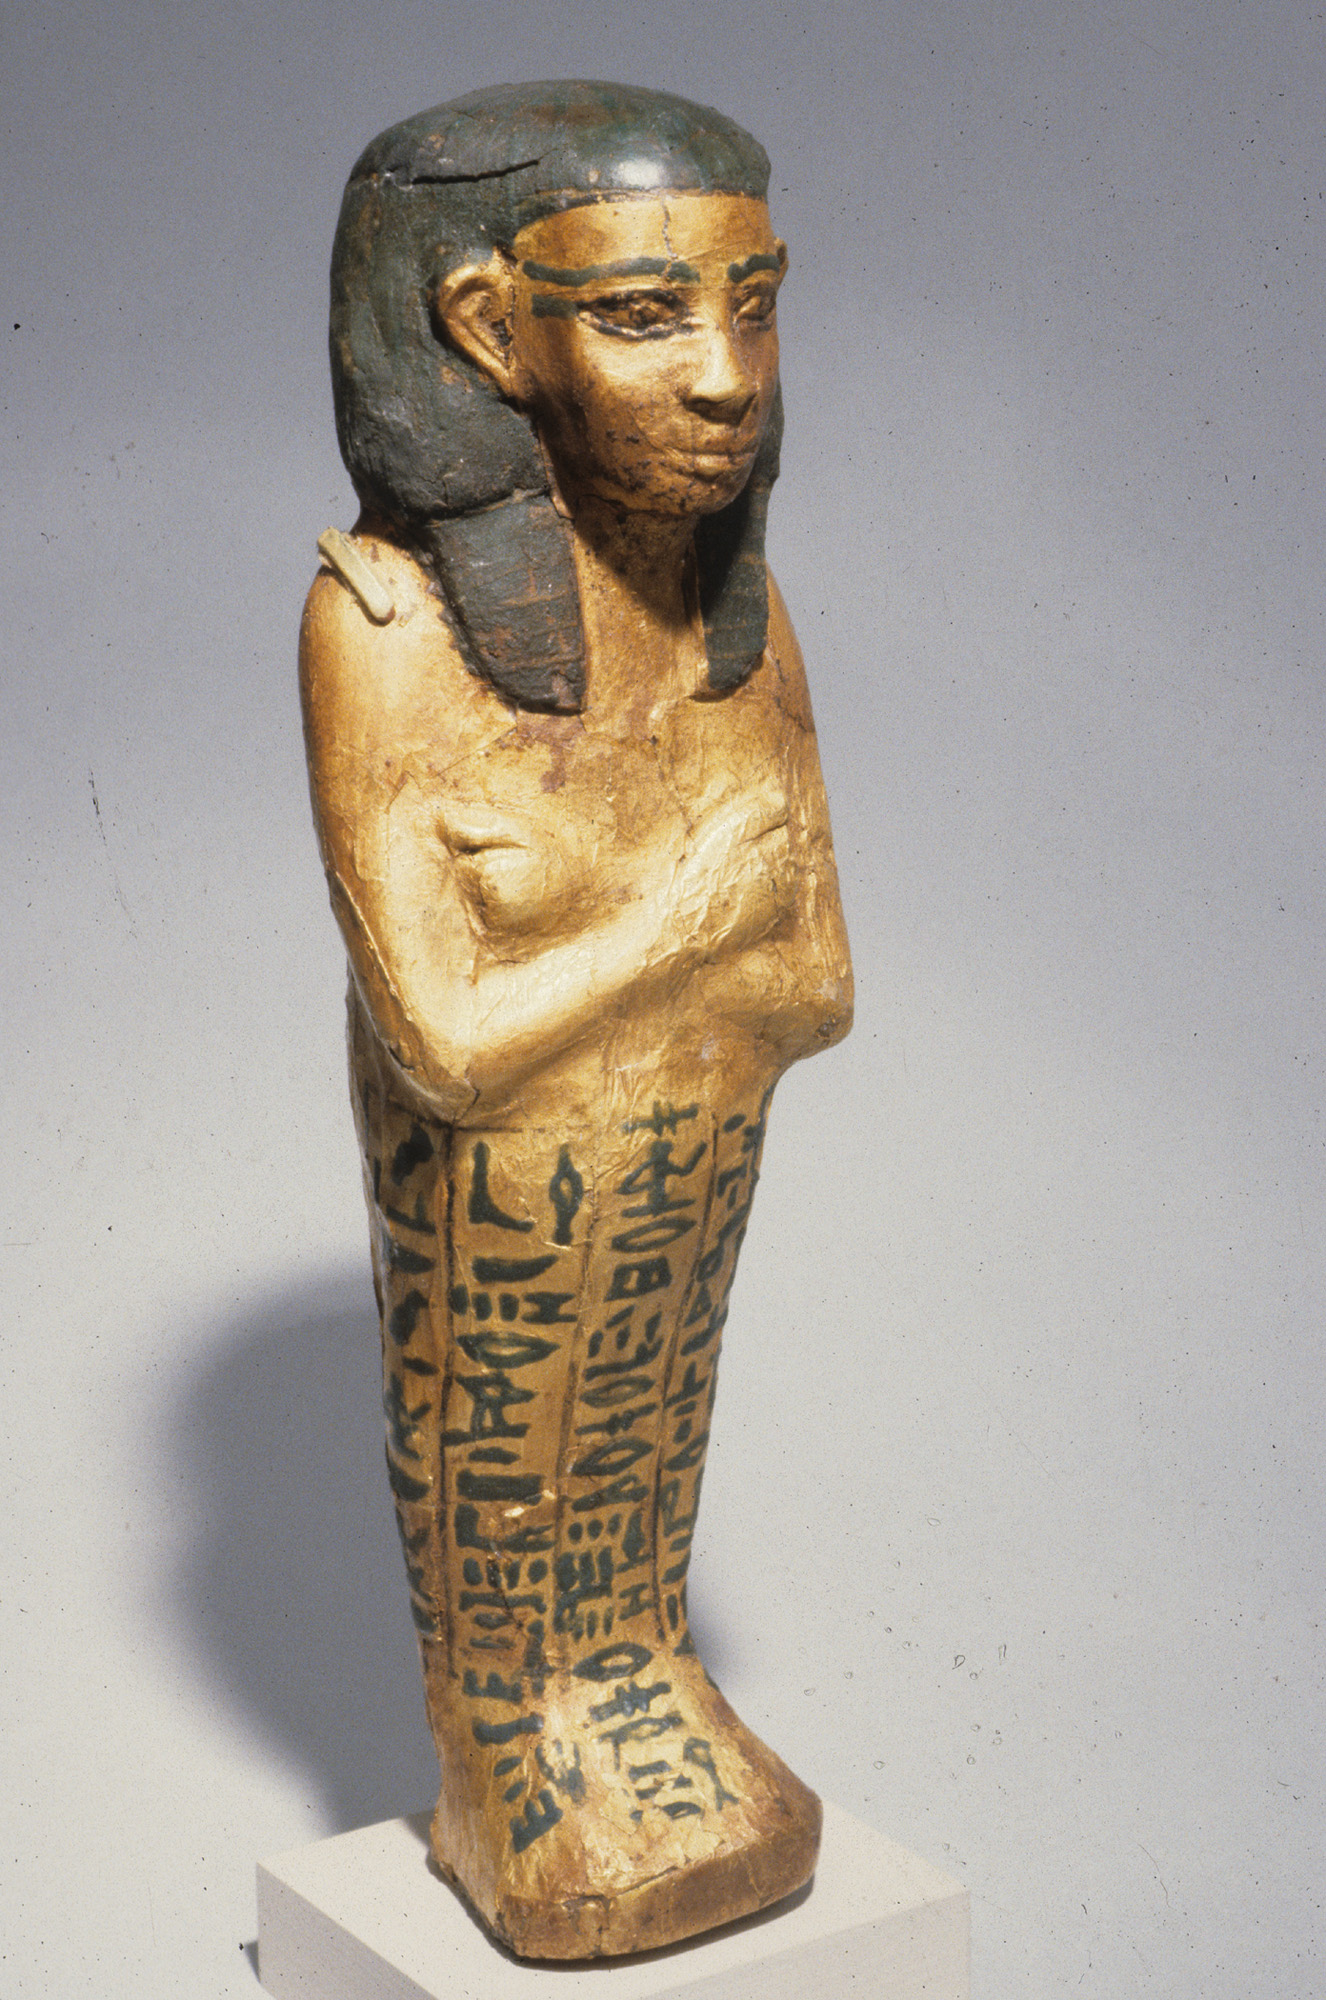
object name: shabti, wahneferhotep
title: Shabti of Wahneferhotep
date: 1981-1640 BCE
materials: gold leaf, paint, wood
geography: egypt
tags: hieroglyphs